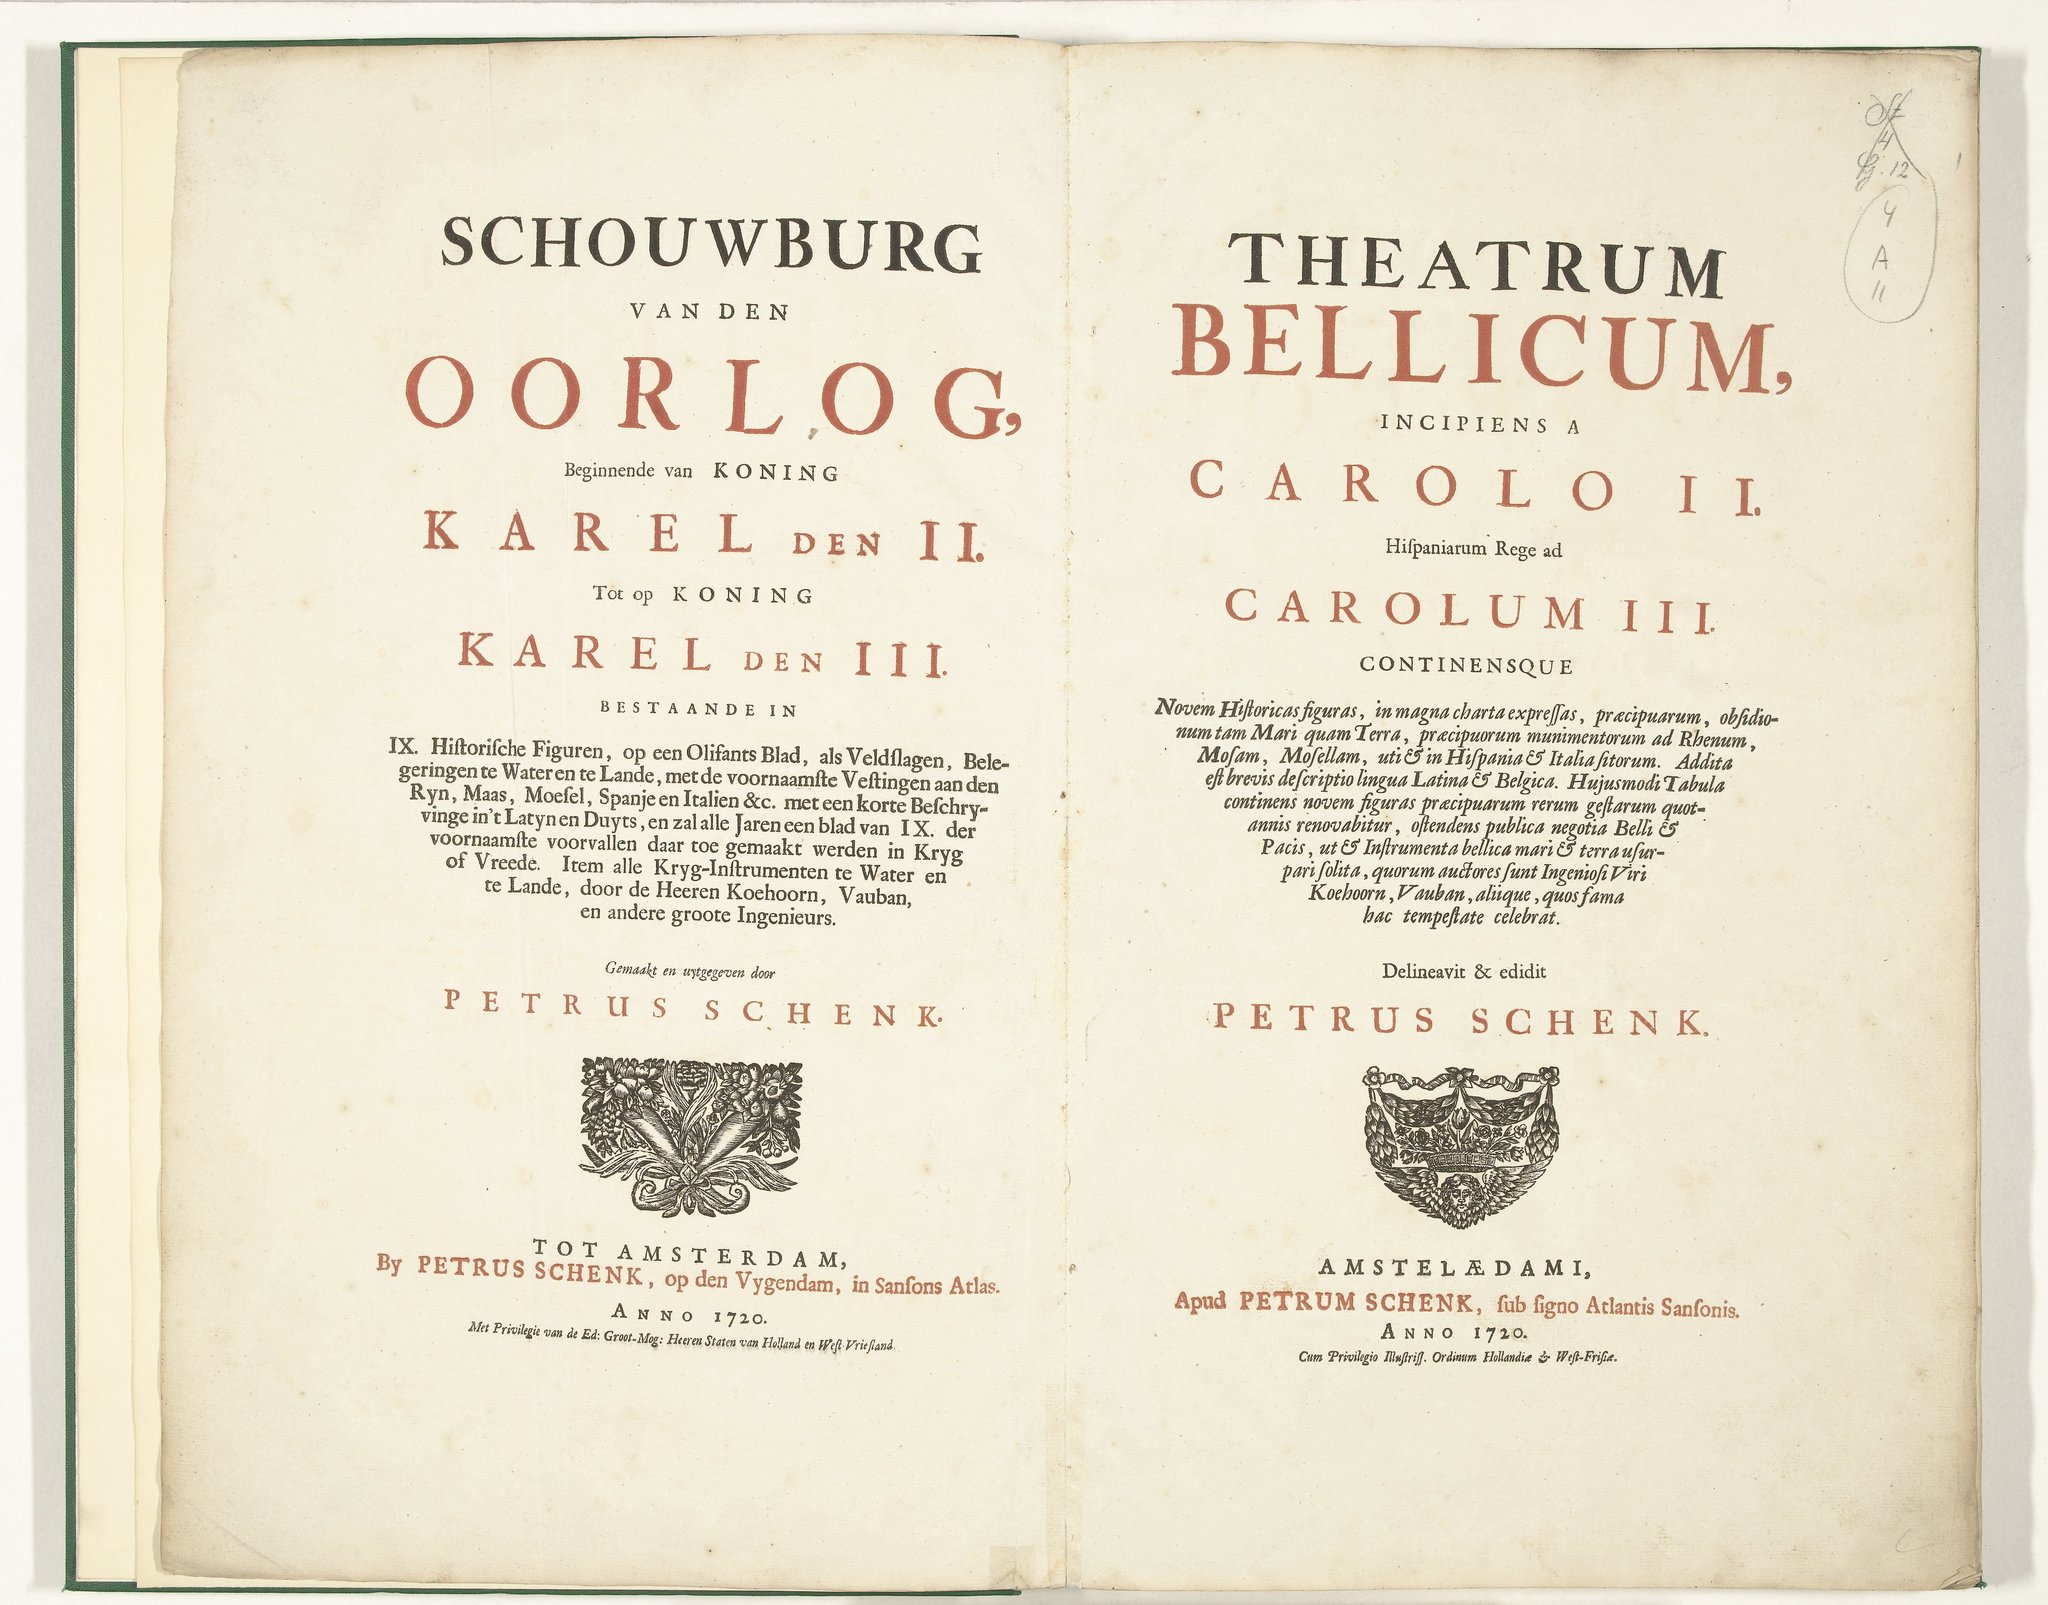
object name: titelblad, titelpagina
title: Schouwburg van den Oorlog, Beginnende van Koning Karel den II. Tot op Koning Karel den III. / Theatrum Bellicum, incipiens a Carolo II. Hispaniarum Rege ad Carolum III.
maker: pieter schenk (i)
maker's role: print maker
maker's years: 1660-1711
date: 1720-1722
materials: paper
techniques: letterpress printing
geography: amsterdam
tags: spaanse successieoorlog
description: Titelpagina gedrukt in zwart en rood in: Schouwburg van den oorlog (editie van 1720), het prentwerk met de gebundelde reeks van 18 platen over de Spaanse Successieoorlog. Volgens het titelblad de editie van 1720, het album is echter samengesteld ca. 1722.